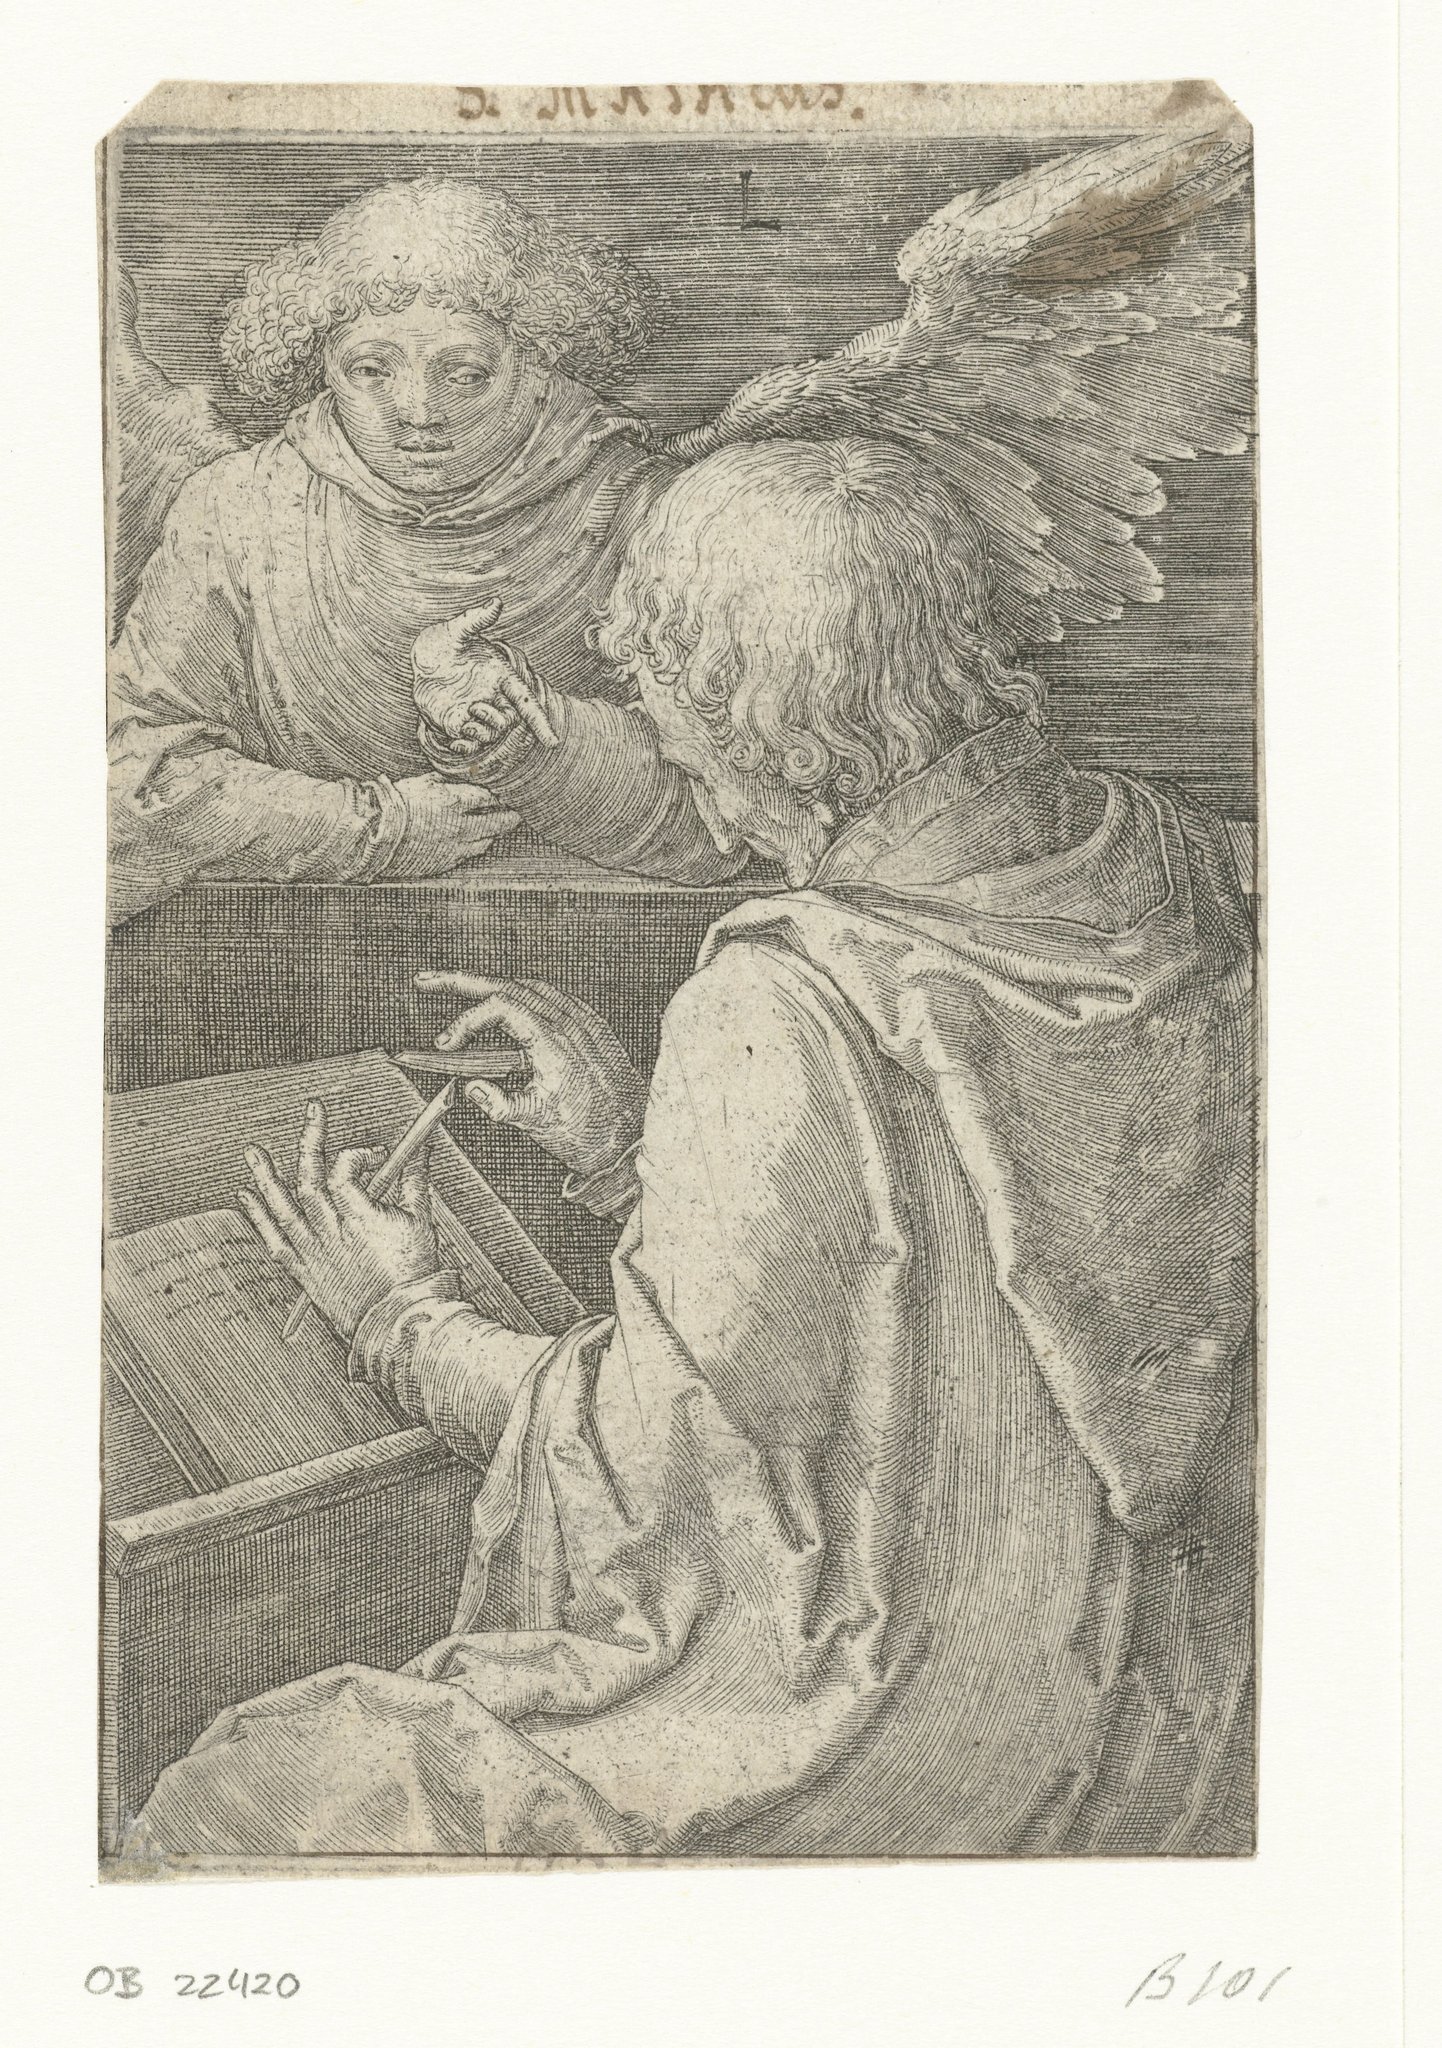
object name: print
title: De evangelist Mattheüs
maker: lucas van leyden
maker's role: draughtsman, painter, print maker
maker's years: 1494-1533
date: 1518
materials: paper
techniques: engraving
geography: low countries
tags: st. matthew writing the gospel, usually the angel present, dictating or assisting him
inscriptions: inscription: ‘S. Matheus.’